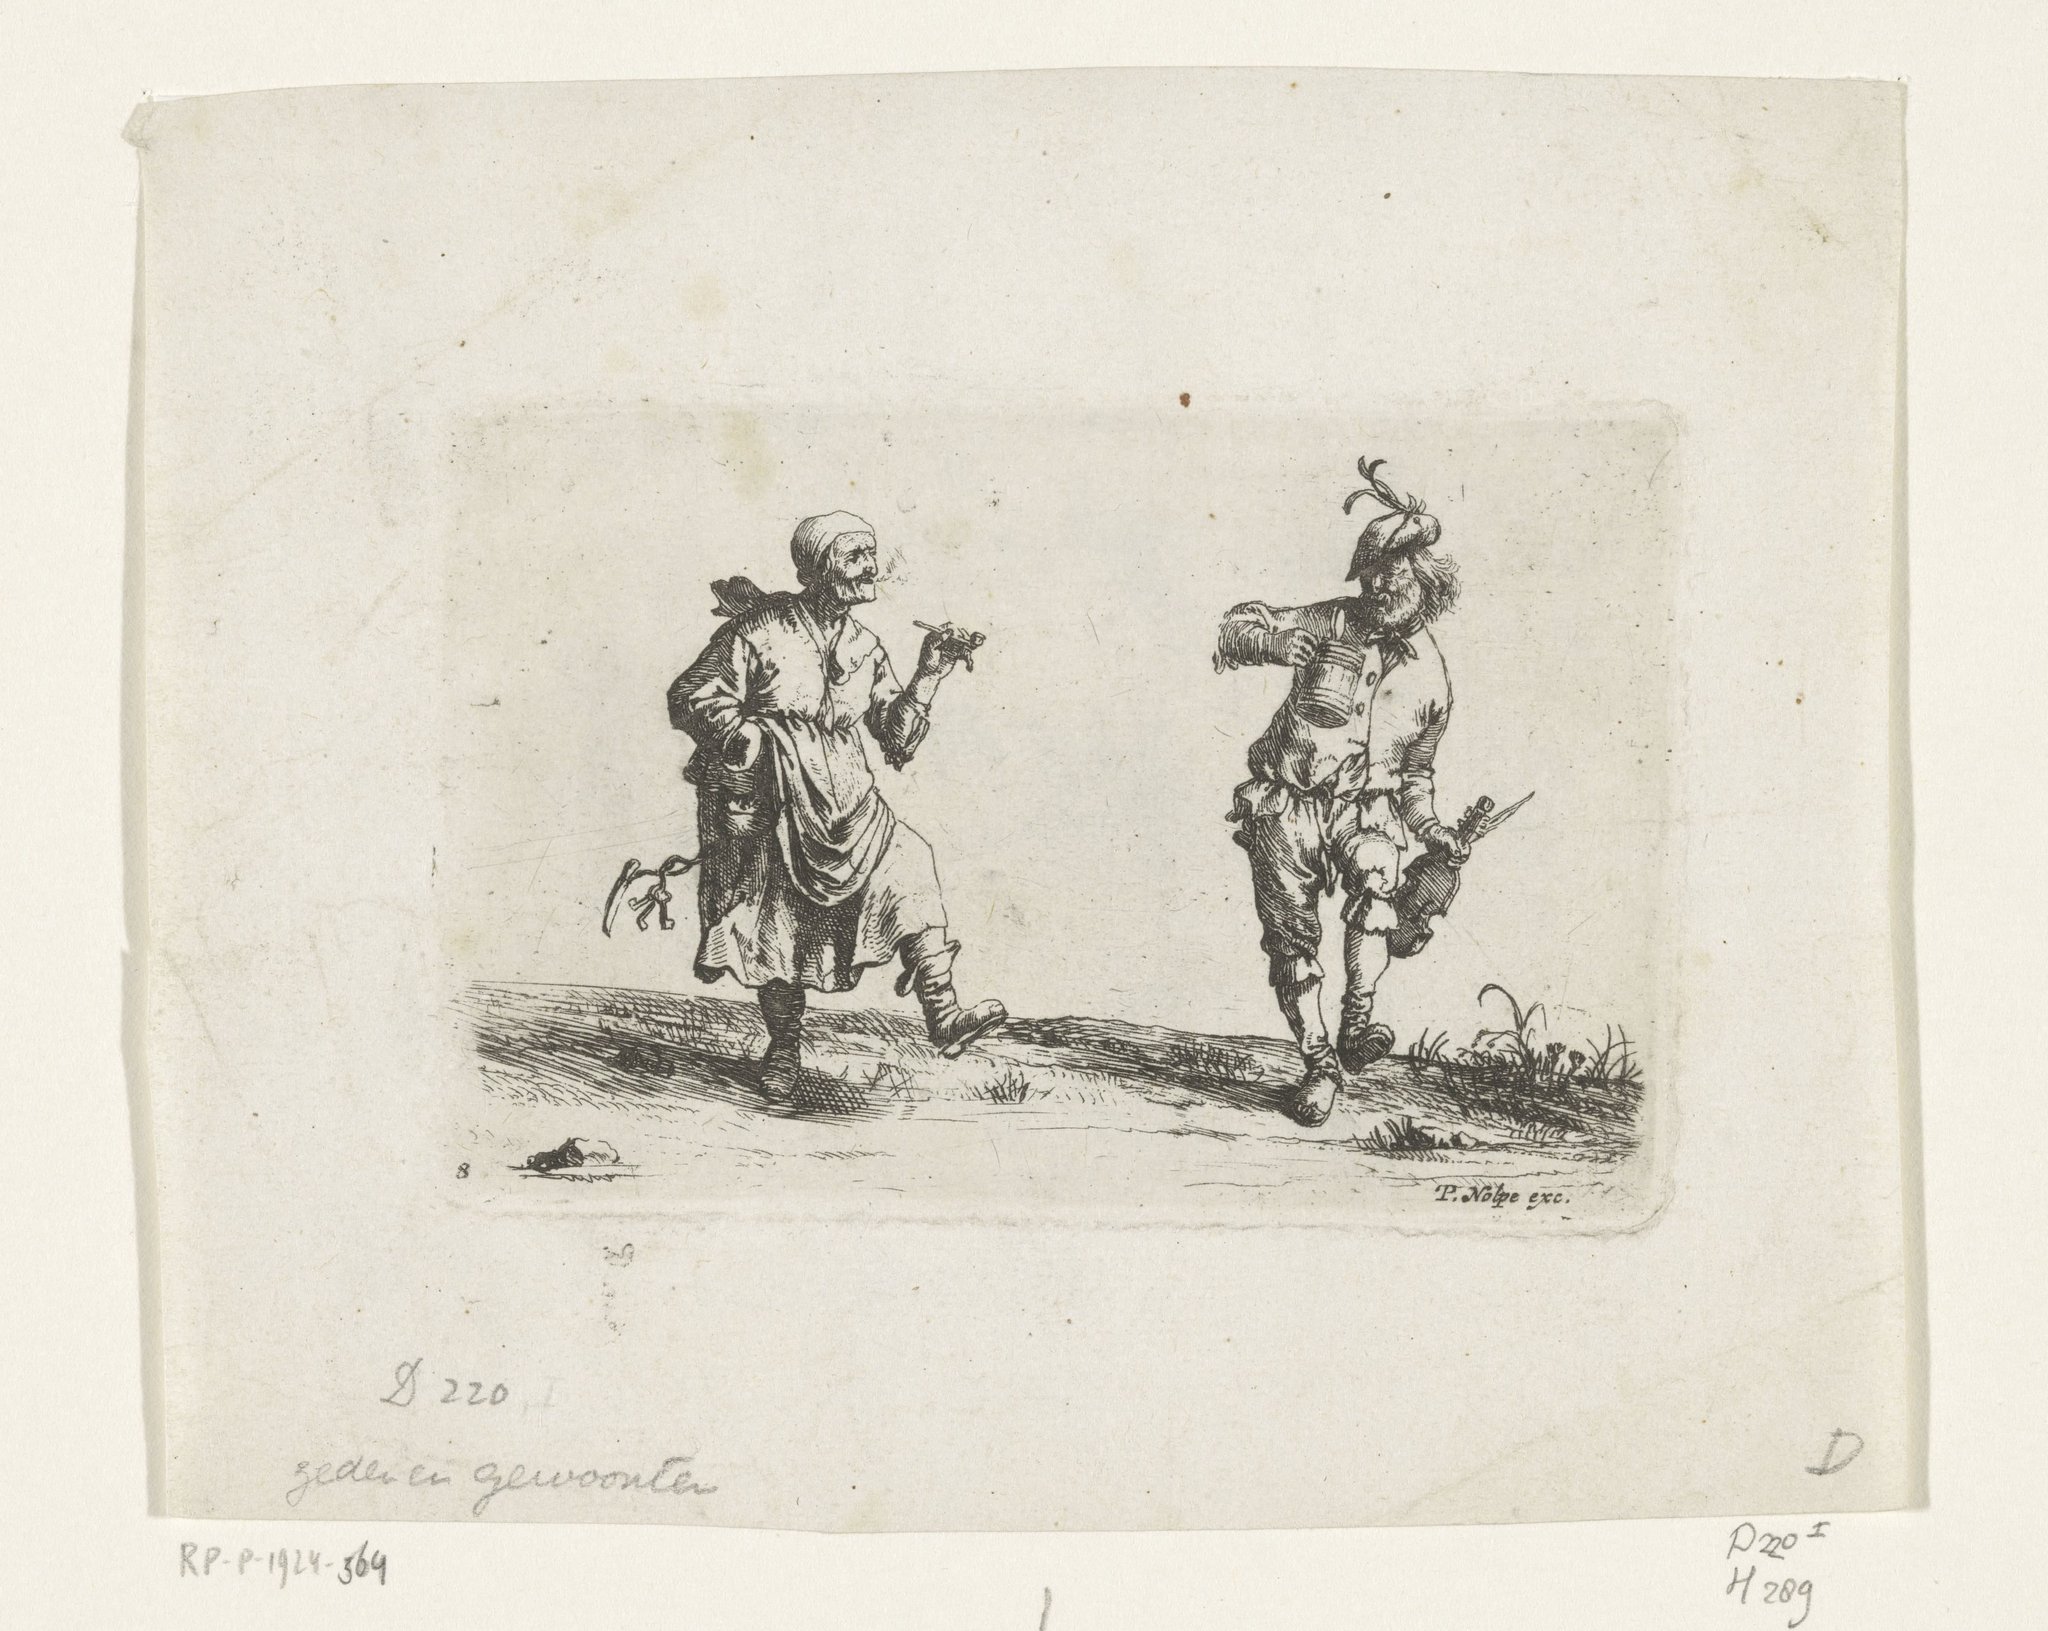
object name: print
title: Dansende boer en boerin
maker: pieter nolpe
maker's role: draughtsman, print maker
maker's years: 1613-1653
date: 1623-1653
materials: paper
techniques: engraving, etching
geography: amsterdam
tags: dancing, violin, fiddle, pipe ~ tobacco, farmers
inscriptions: collector's mark: Lugt 2228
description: Een boerin en een boer dansen naast elkaar in het gras. De boerin rookt een pijpje en heeft een sleutelbos en een mes aan haar kleed hangen. De boer houdt een drinkbeker in de ene en een viool in de andere hand. Prent maakt deel uit van een serie met scènes uit het boerenleven.